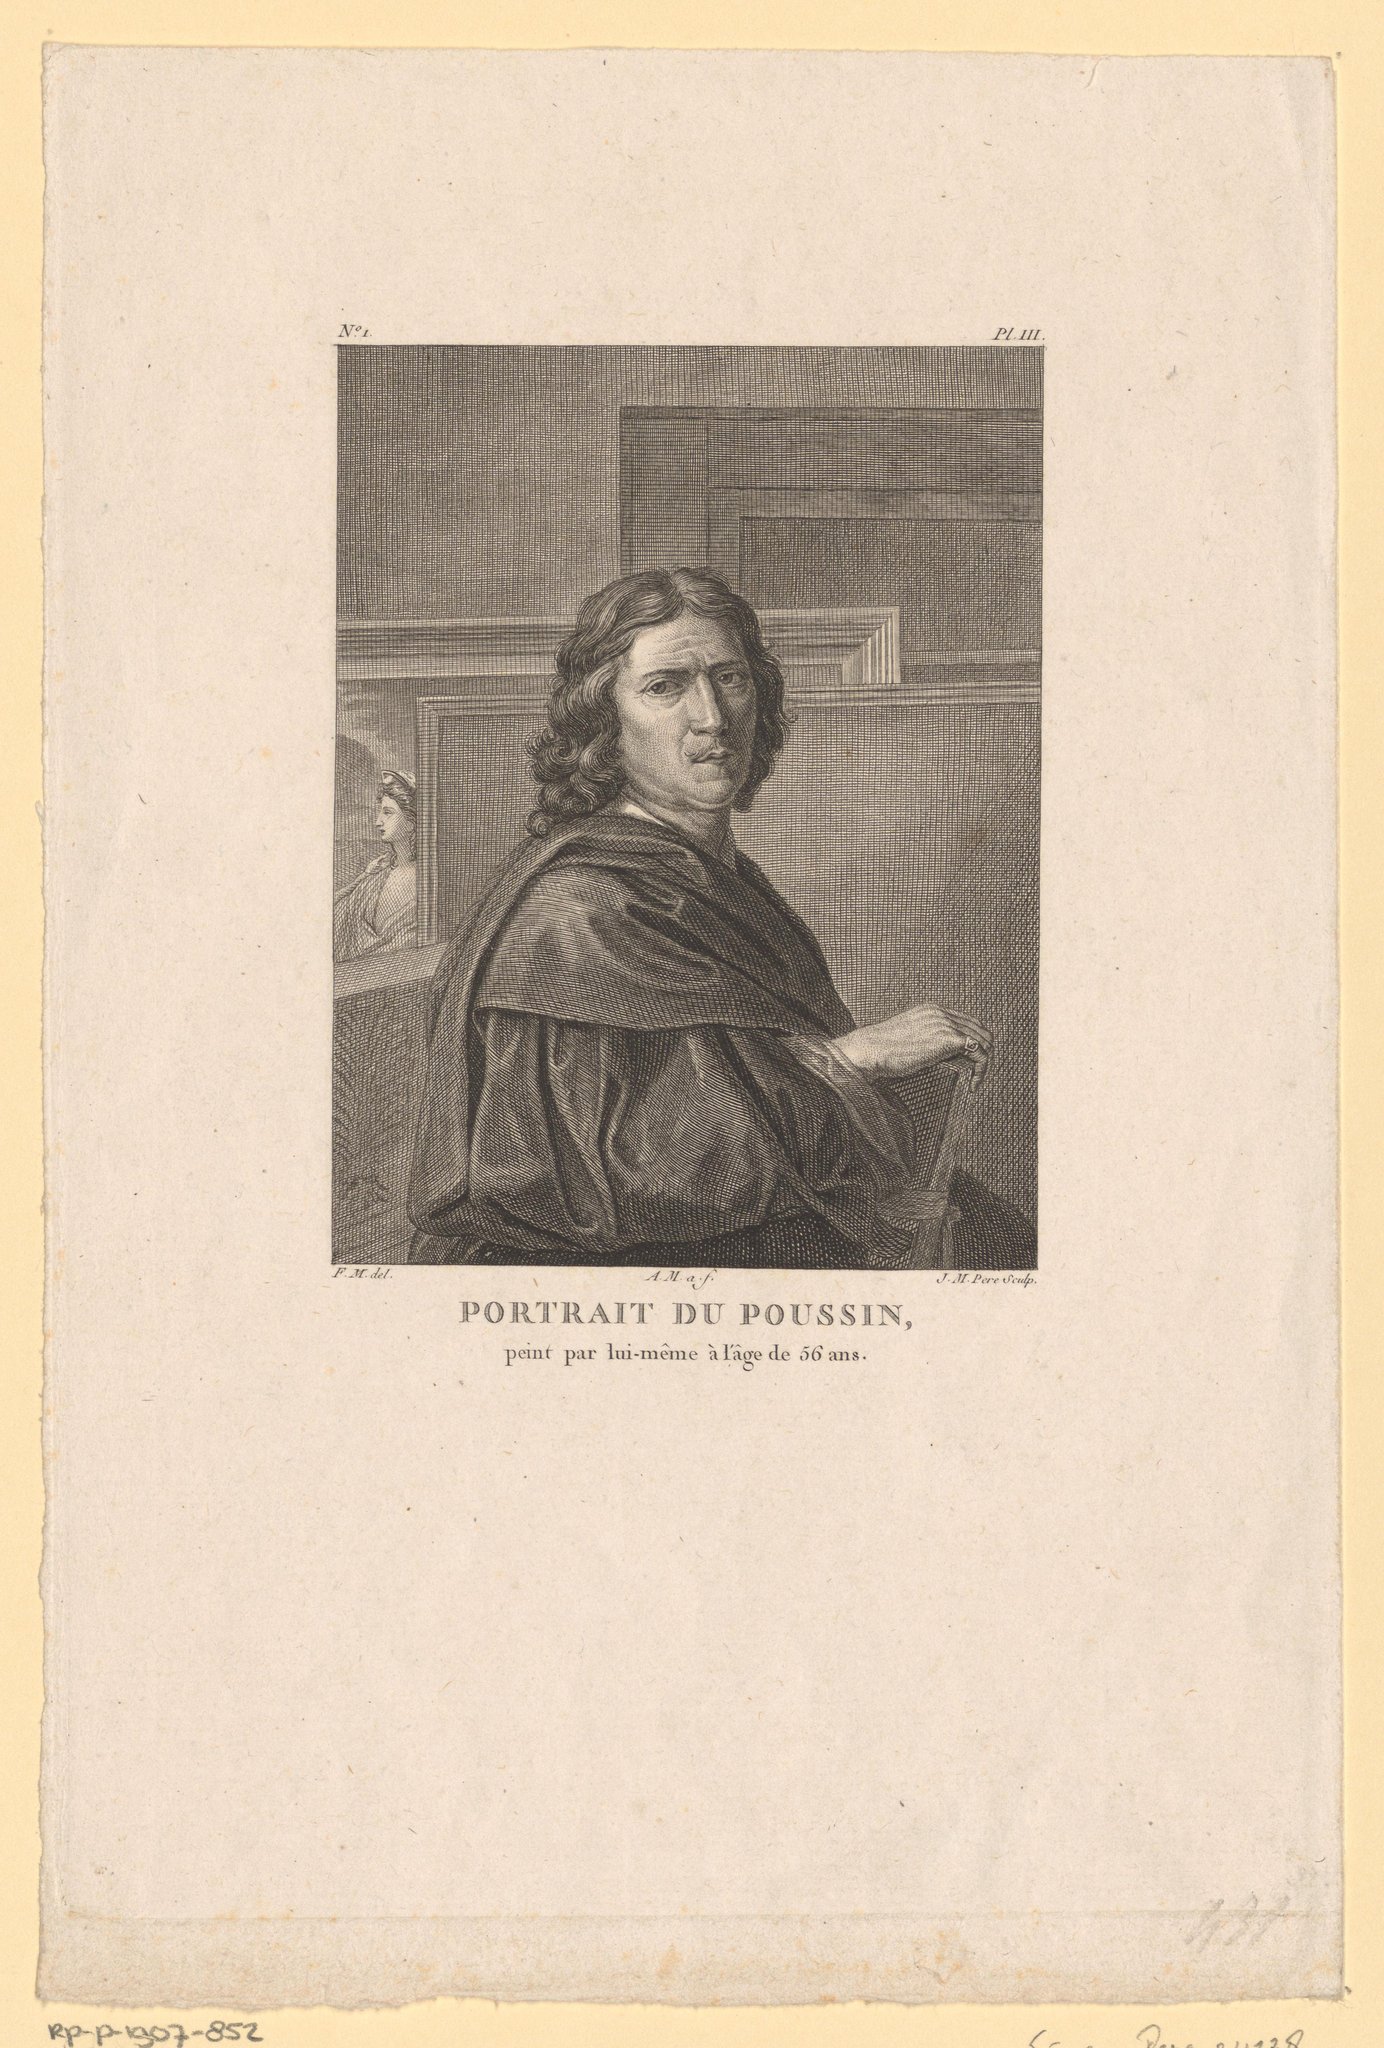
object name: print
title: Portret van Nicolas Poussin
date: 1803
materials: paper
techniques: engraving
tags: rome, painter, draughtsman, nicolas poussin, historical persons, portrait, self-portrait of painter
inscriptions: collector's mark: Lugt 2228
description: Prent waarschijnlijk uit: Gault de Saint-Germain, Pierre Marie. Vie de Nicolas Poussin, considéré comme chef de l'Ecole françoise, précédée d'un précis historique des peintres françois, depuis le règne de François I jusqu'au règne de Louis XIV. Parijs: Perlet, 1803.